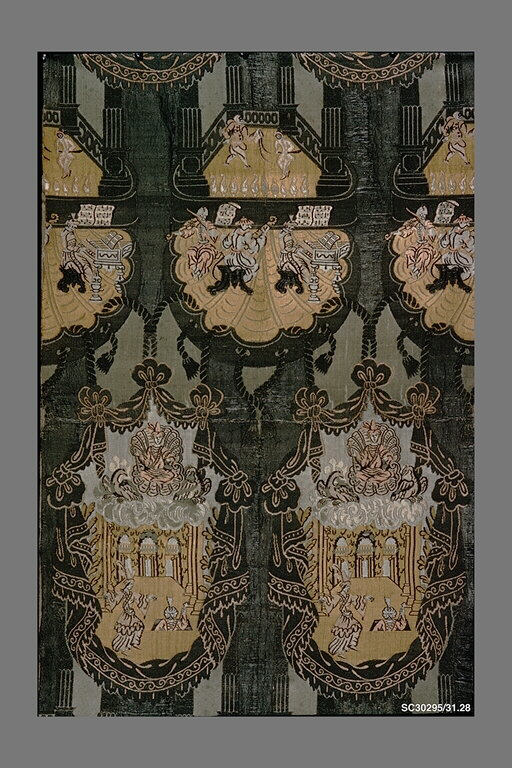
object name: piece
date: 1701-1733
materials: metal thread, silk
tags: human figures